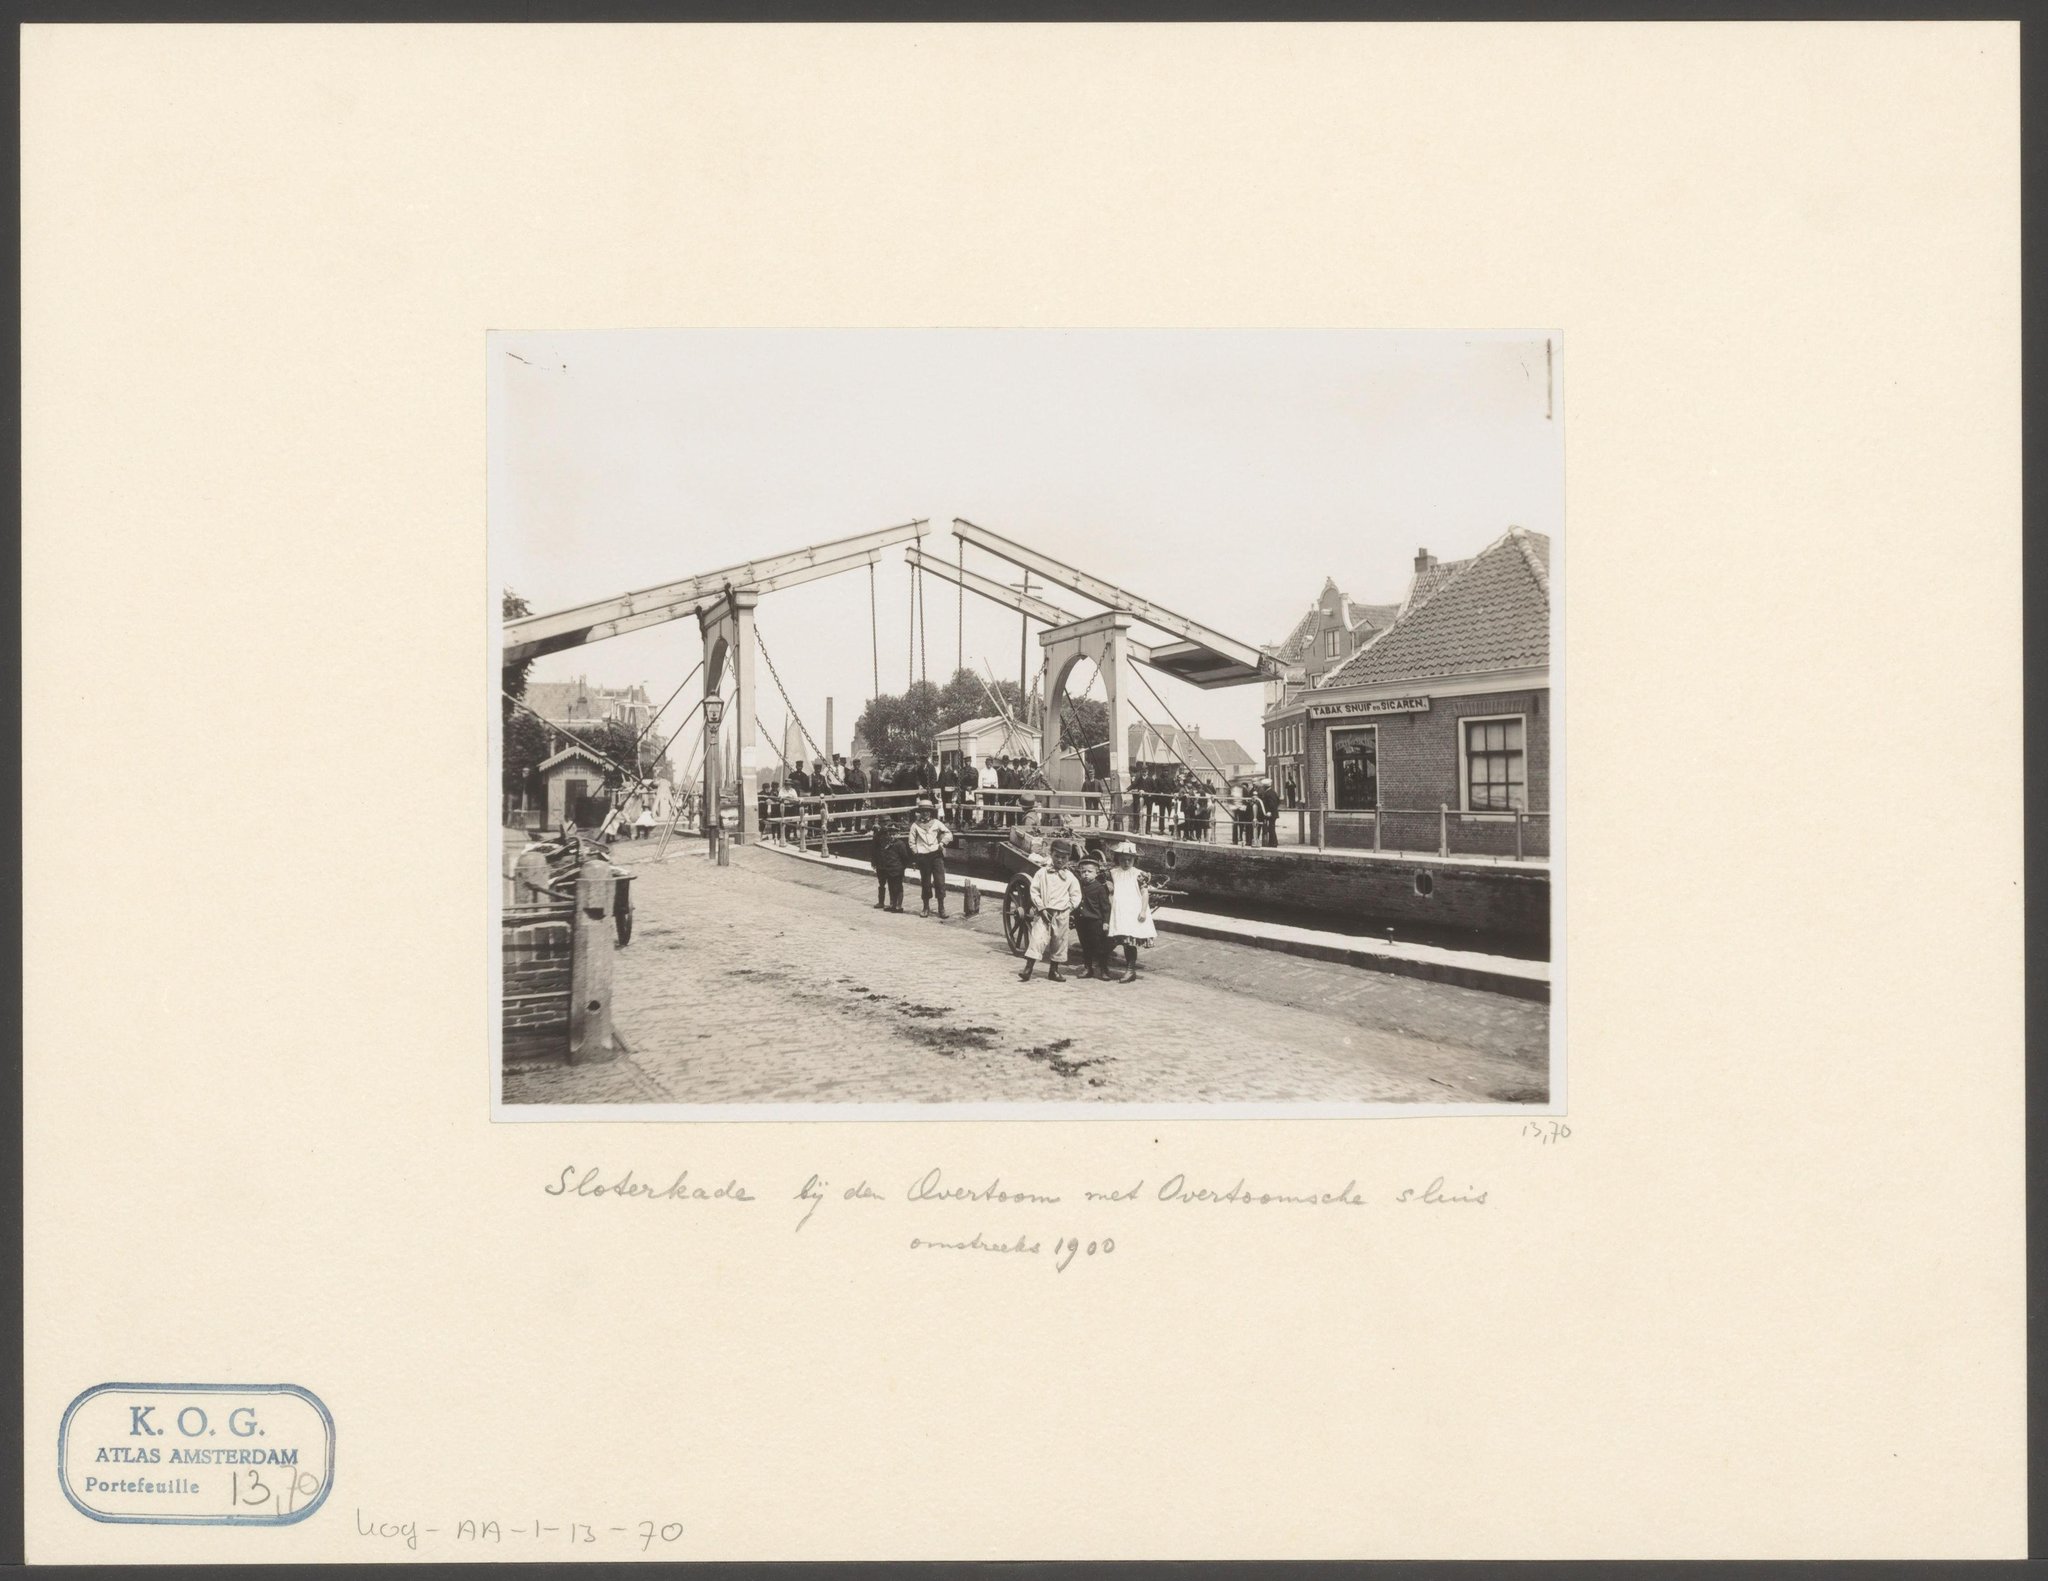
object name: photograph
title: Gezicht op de Sloterkade bij de Overtoomse Sluis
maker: Anonymous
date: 1900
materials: paper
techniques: gelatin silver print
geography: amsterdam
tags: sluice, weir, city-view in general; 'veduta', canal, street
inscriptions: collector's mark: ‘13,70’ Lugt 1641b, inscription: ‘Sloterkade bij den Overtoom met Overtoomsche sluis / omstreeks 1900’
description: Onderwerpsrubriek binnen de Atlas Amsterdam: Slatuinenpad, Sloterkade, Slootstraat, Slijkstraat, Snoekjesgracht, Sophiapark, Spaarndammerdijk, Spiegelgracht, Spinhuissteeg, Spui, Spuistraat (ook lage Erf), Staalstraat, Stadhouderskade, Steenpad, Stroomarkt.